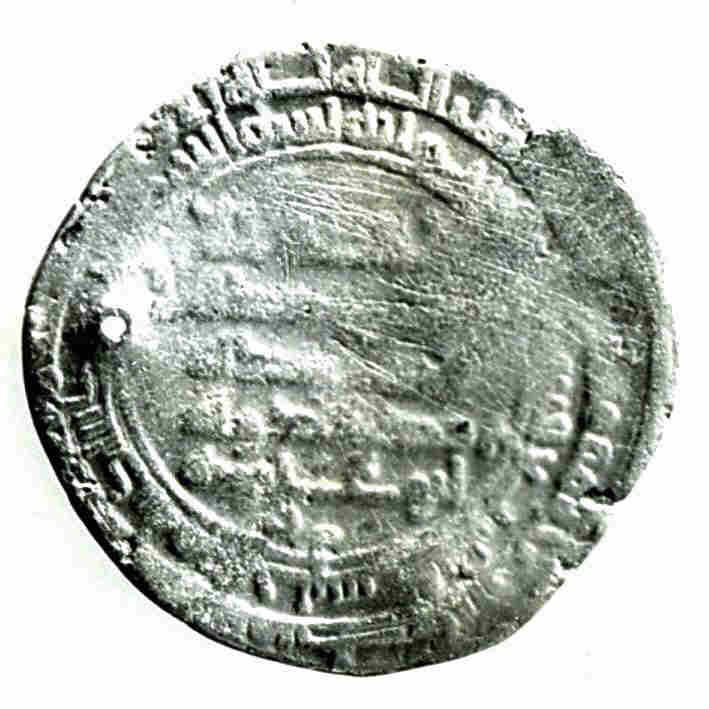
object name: coin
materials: silver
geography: iran